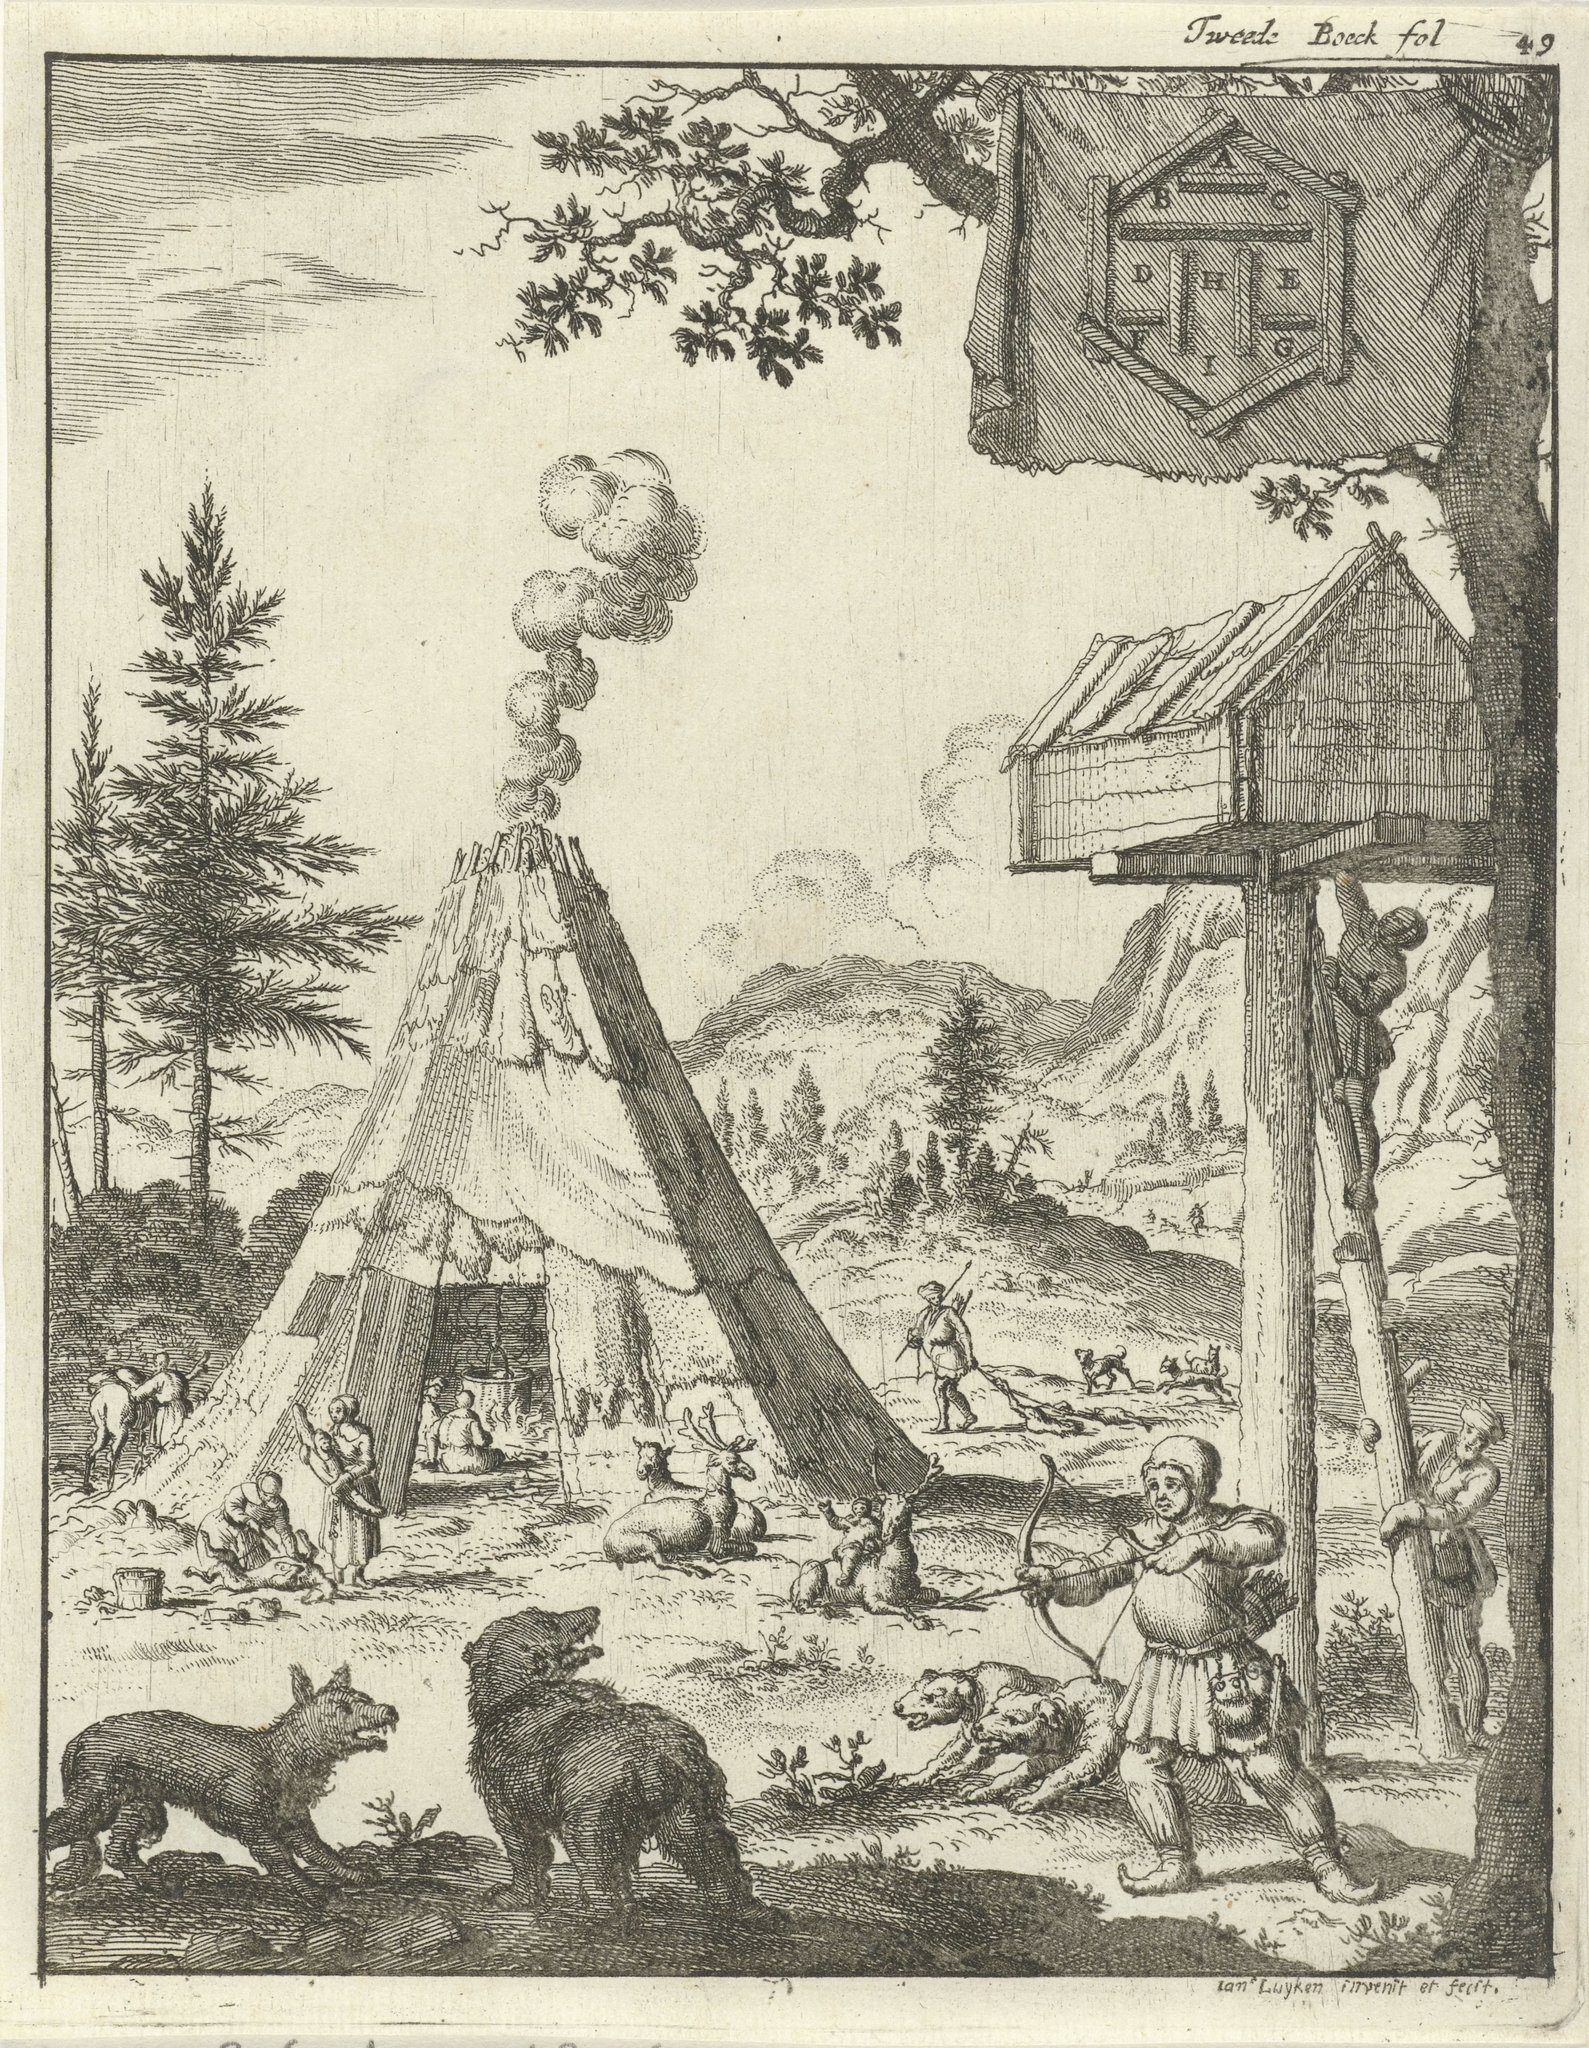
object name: print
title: Same richt zijn pijl en boog op een wolf en een beer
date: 1682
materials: paper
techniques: etching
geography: amsterdam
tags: europeans: sami, archer's weapons: arrow, beasts of prey, predatory animals: bear, beasts of prey, predatory animals: wolf, sápmi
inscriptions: collector's mark: Lugt 2228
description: Illustratie opgenomen in: Scheffer, Johannes. Waarachtige en aen-merkens-waardige historie van Lapland. Amsterdam: Jan Claesz ten Hoorn, 1682.